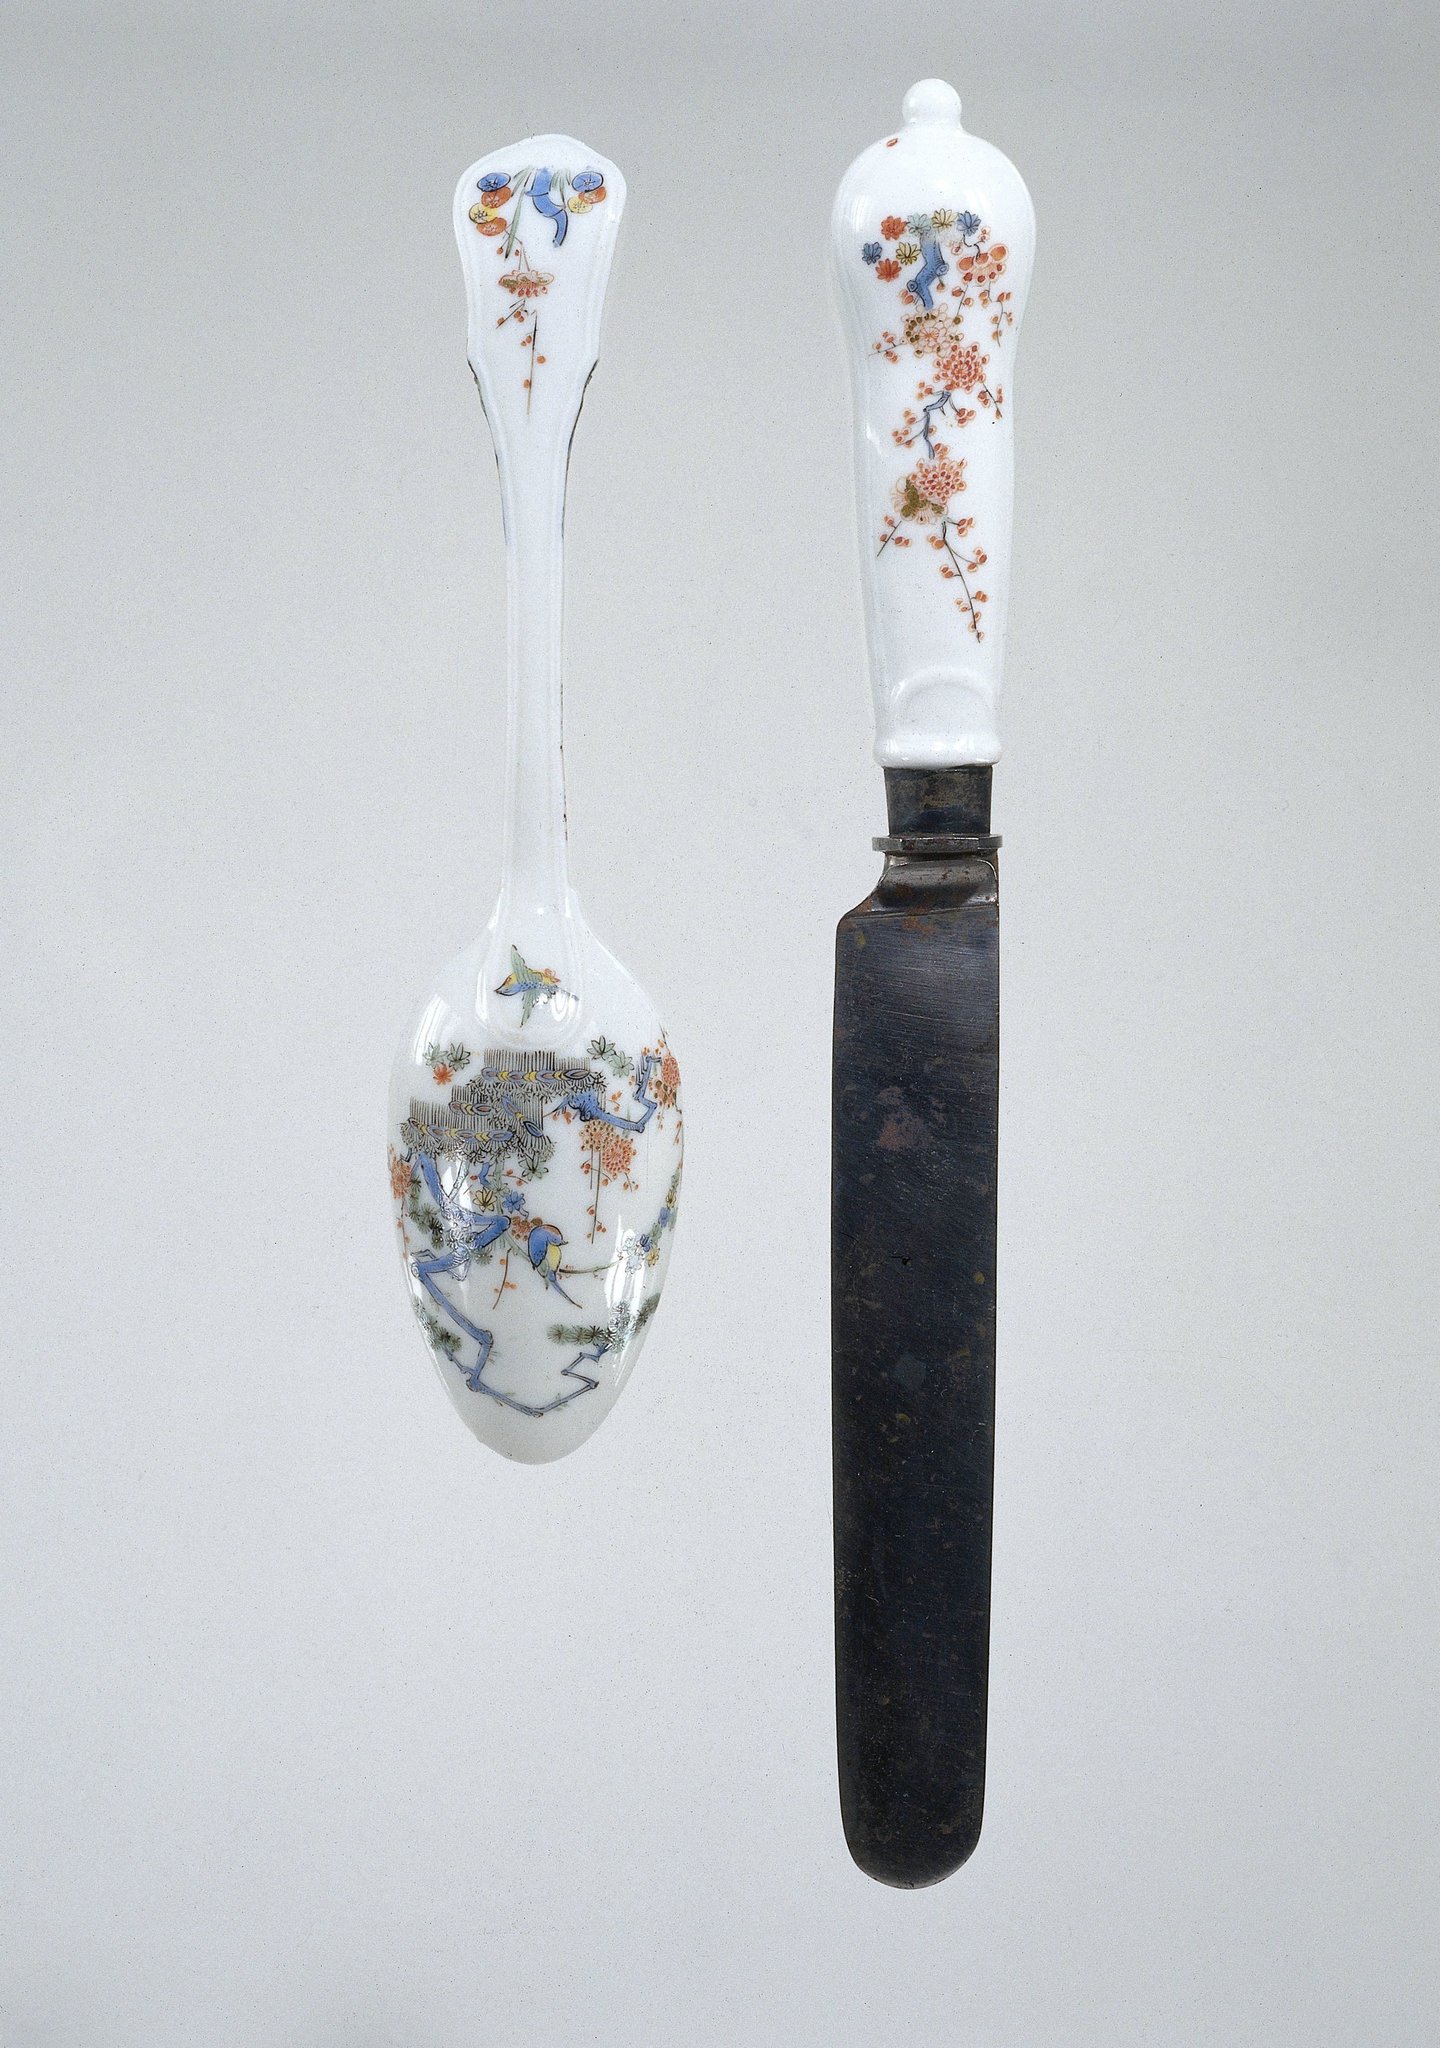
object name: table knife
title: Mes met heft, veelkleurig beschilderd met een Kakiemon-decor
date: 1730-1735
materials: porcelain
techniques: painted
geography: meissen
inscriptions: mark: ‘[.]OSFELD’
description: Spoon and knife handle. Meissen, c. 1730 - 1740.